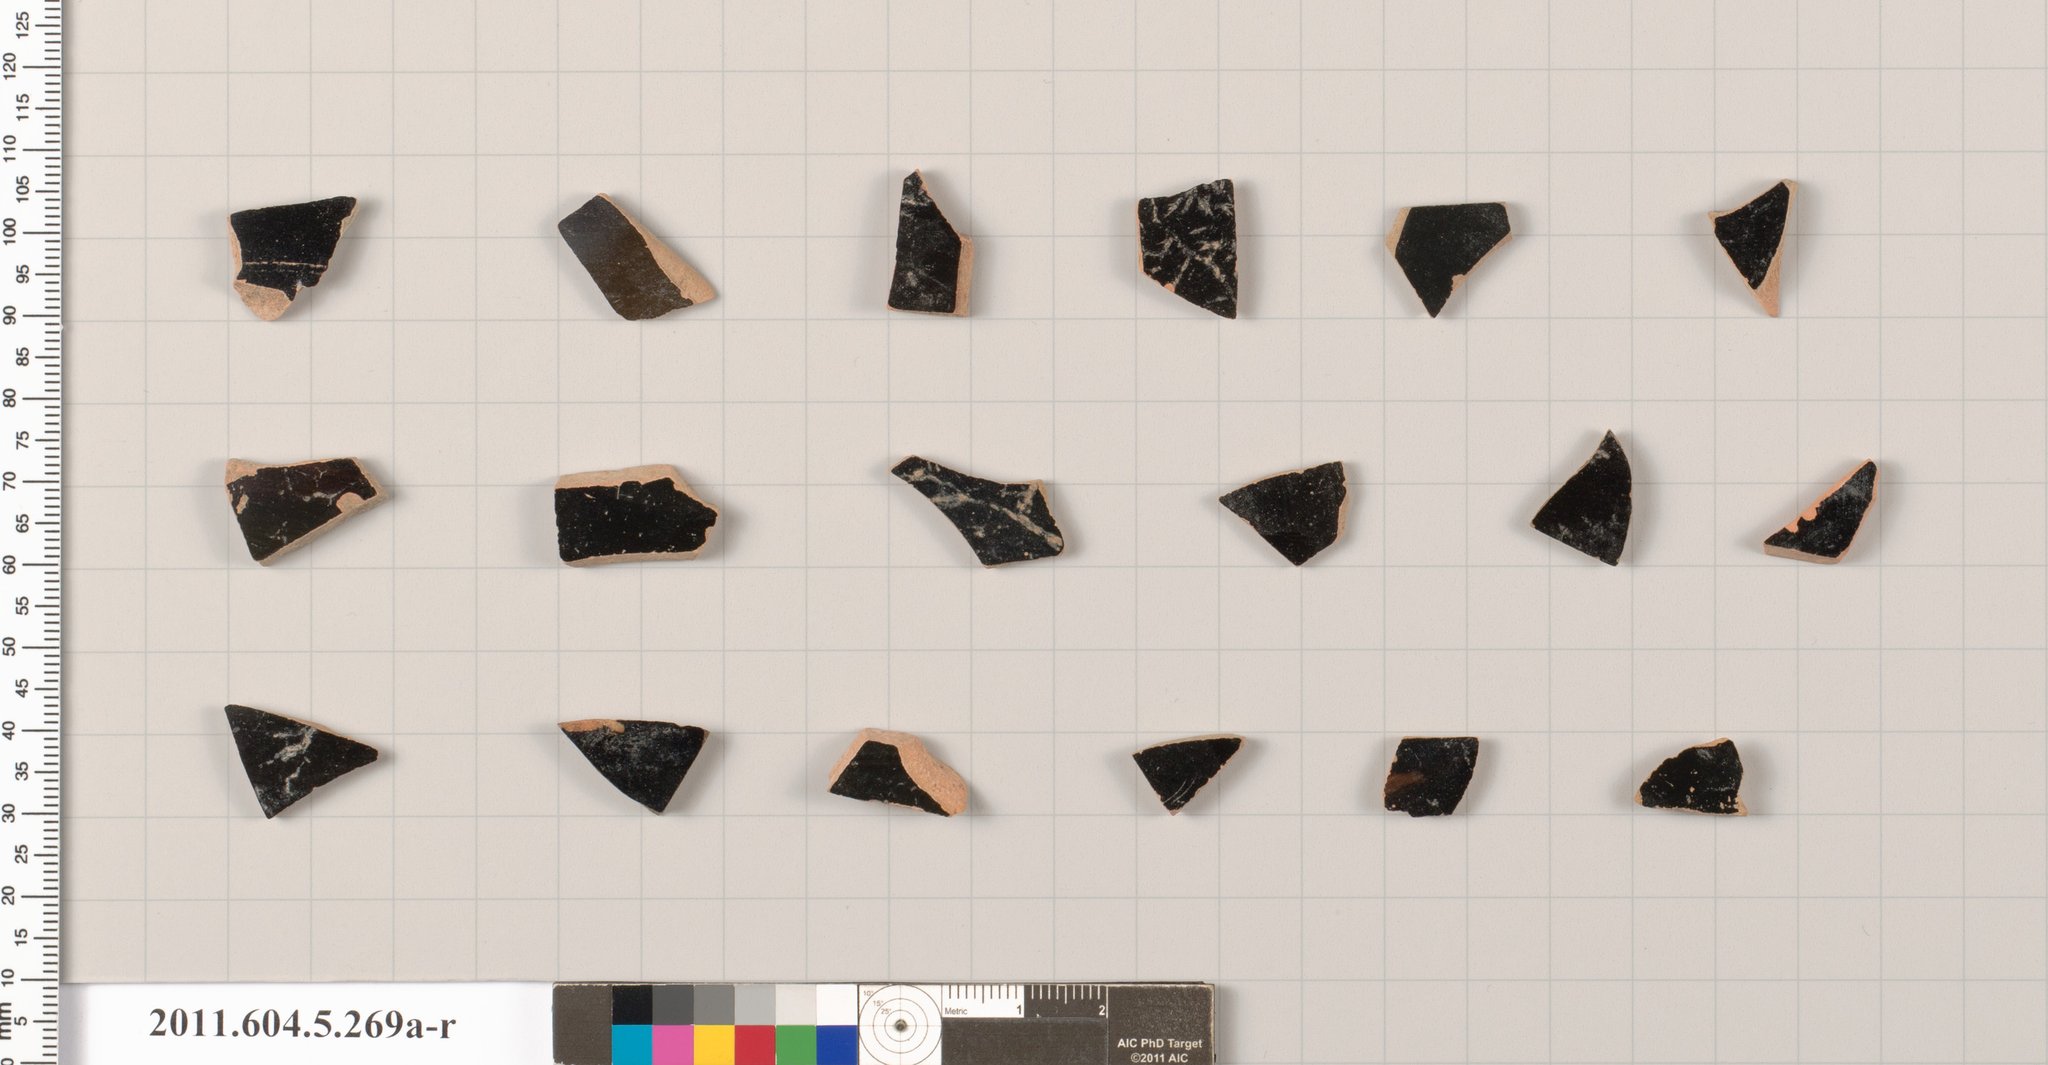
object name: kylix fragment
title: Terracotta fragments of kylikes (drinking cups)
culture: greek, attic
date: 600-401 BCE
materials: terracotta